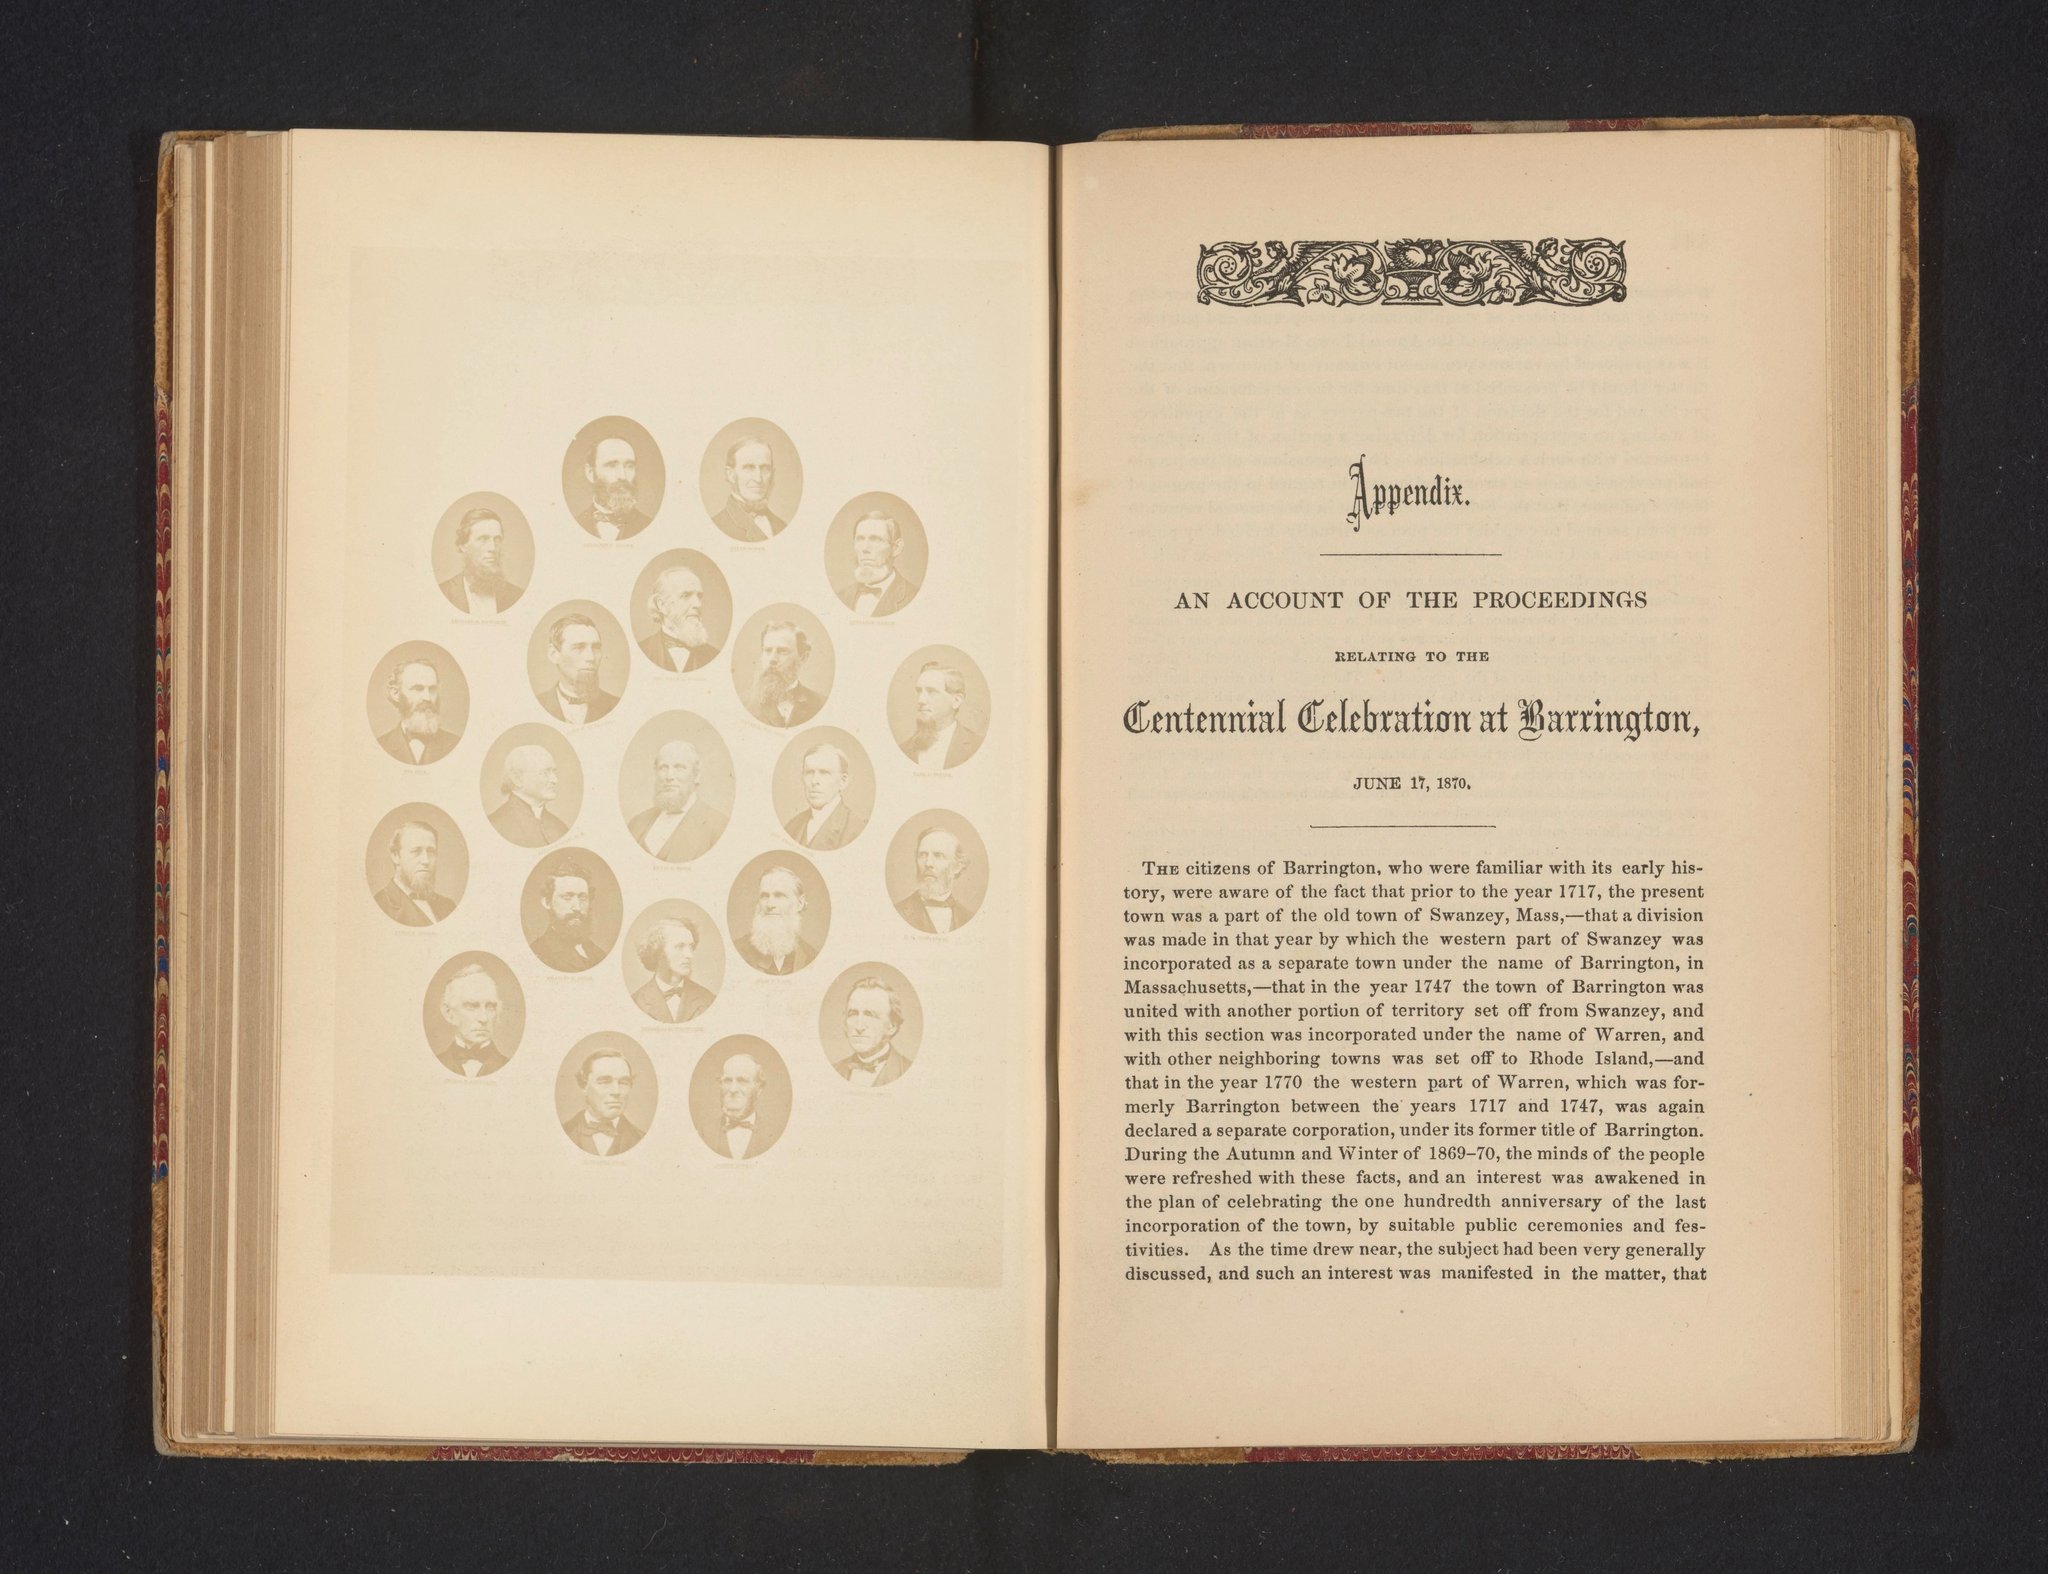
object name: page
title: Portretten van de leden van het Centennial Committee van Barrington, Rhode Island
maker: Anonymous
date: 1865-1870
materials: photographic support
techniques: salted paper print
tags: historical persons, anonymous historical persons portrayed in a group, in a group-portrait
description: Foto op de derde ongenummerde pagina na pagina 141.